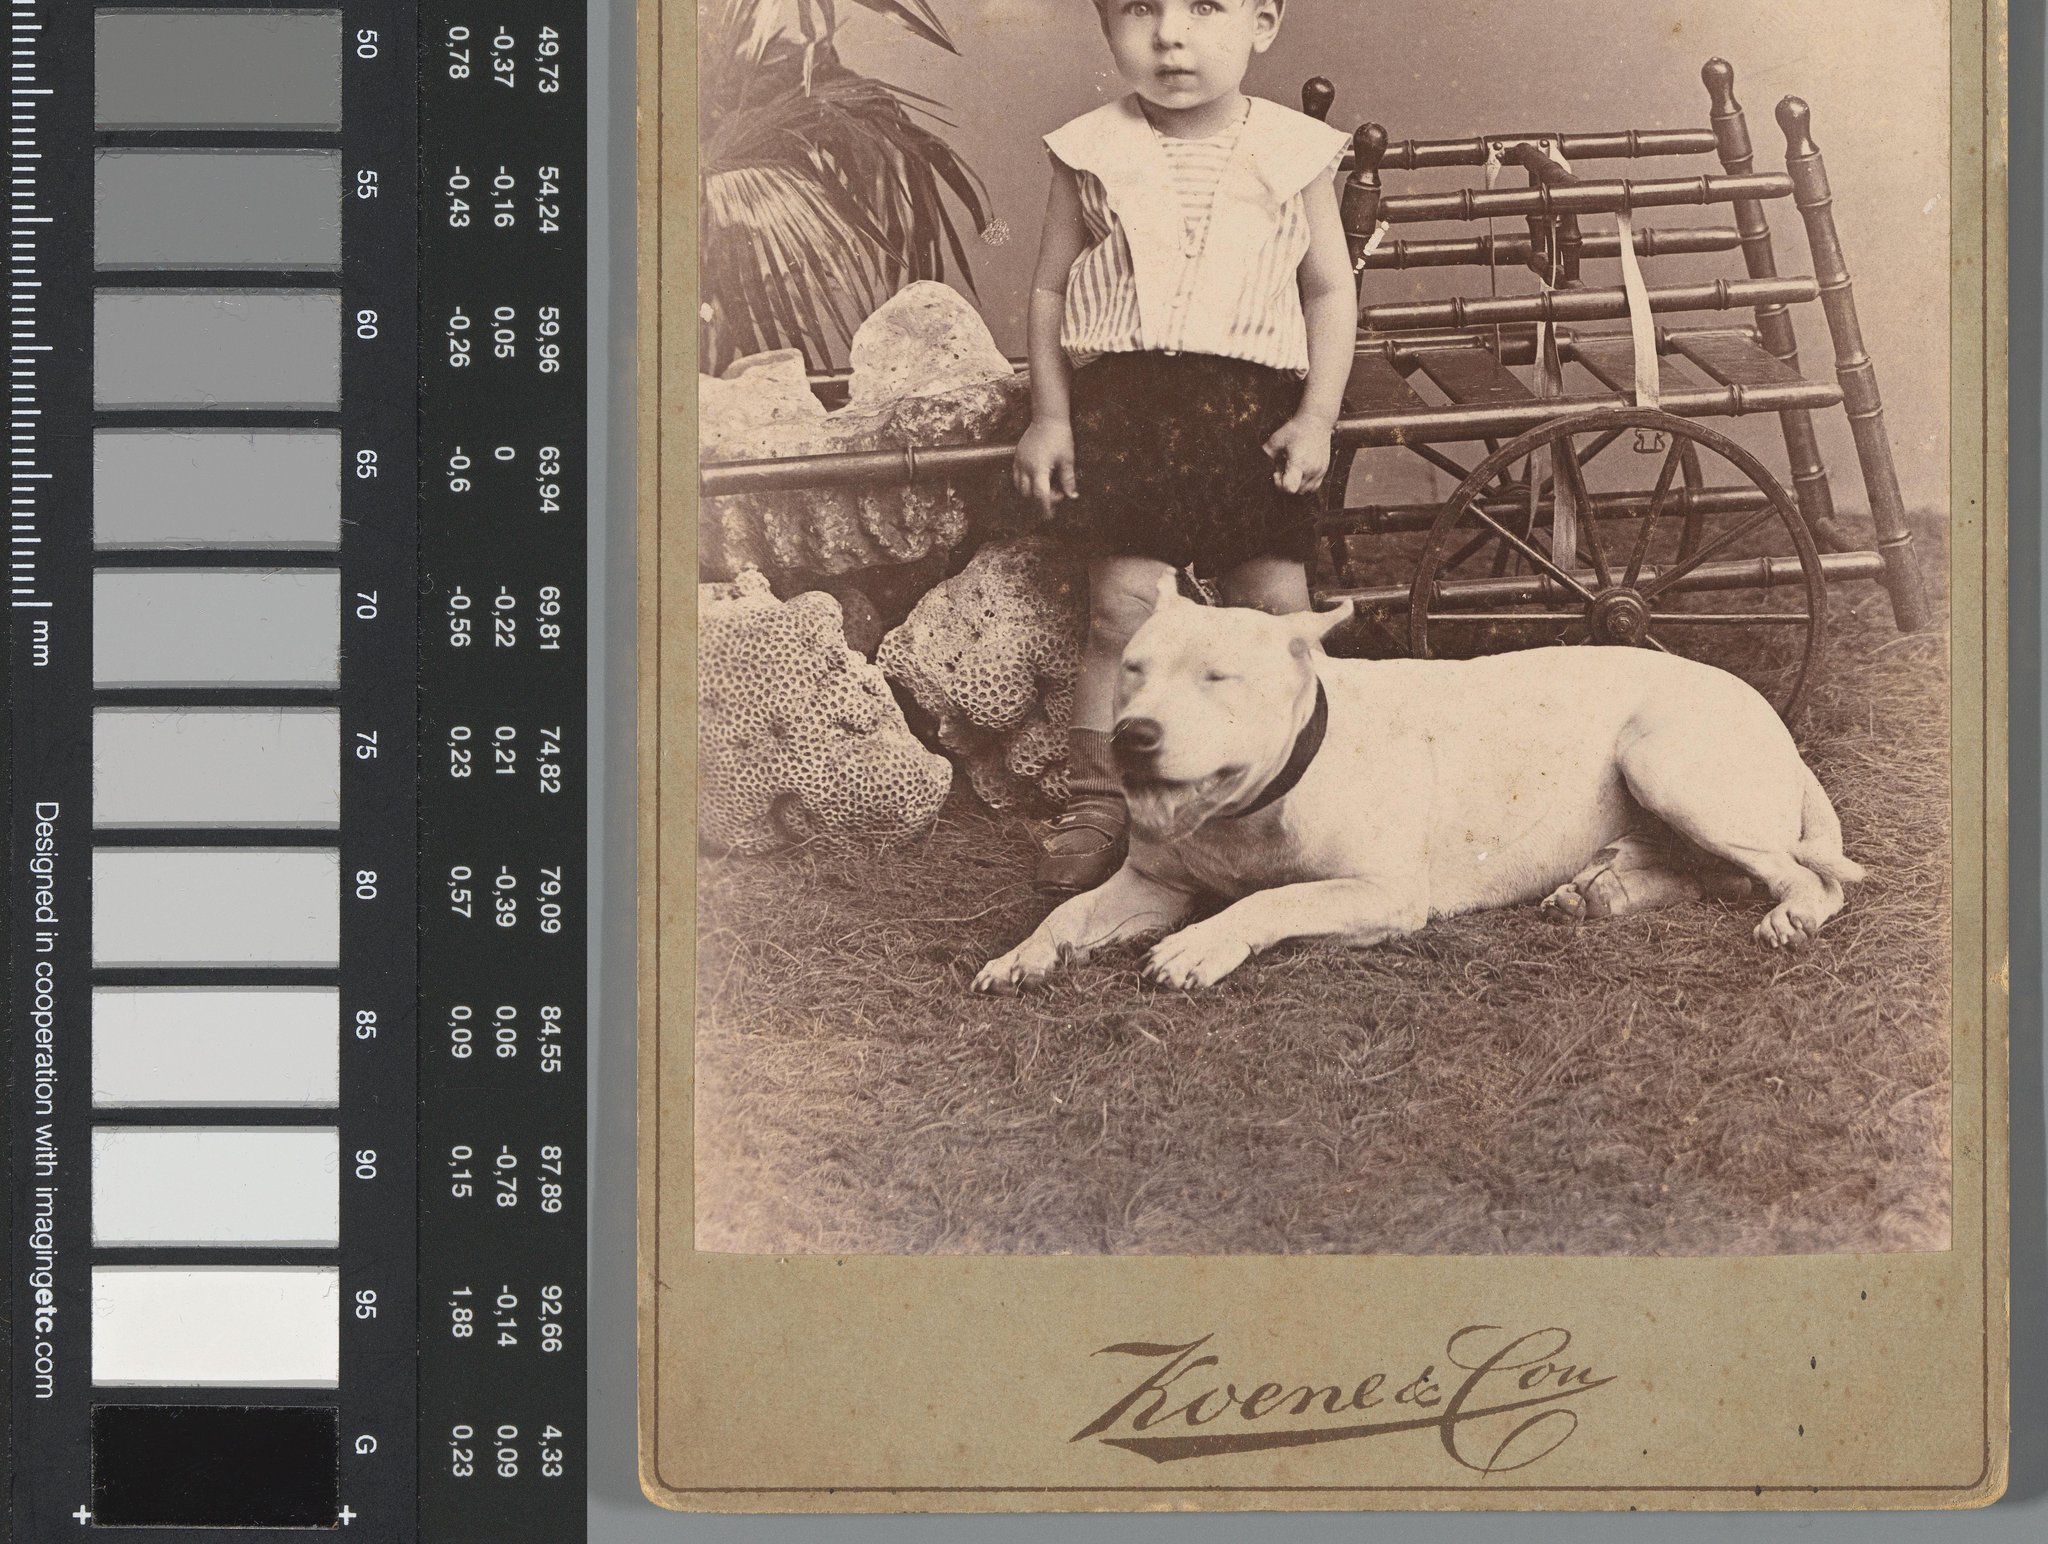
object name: cabinet photograph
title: Studioportret van kind van Emilie van den Berg en Piet Onnen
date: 1890-1920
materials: cardboard, photographic support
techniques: albumen print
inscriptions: name: ‘BATAVIA / Koene & Co / AMSTERDAM / ALKMAAR’, name: ‘Koene & Co’, inscription: ‘oud 2 jaar’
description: Kind van 2 jaar oud, staand met een hond aan zijn voeten.